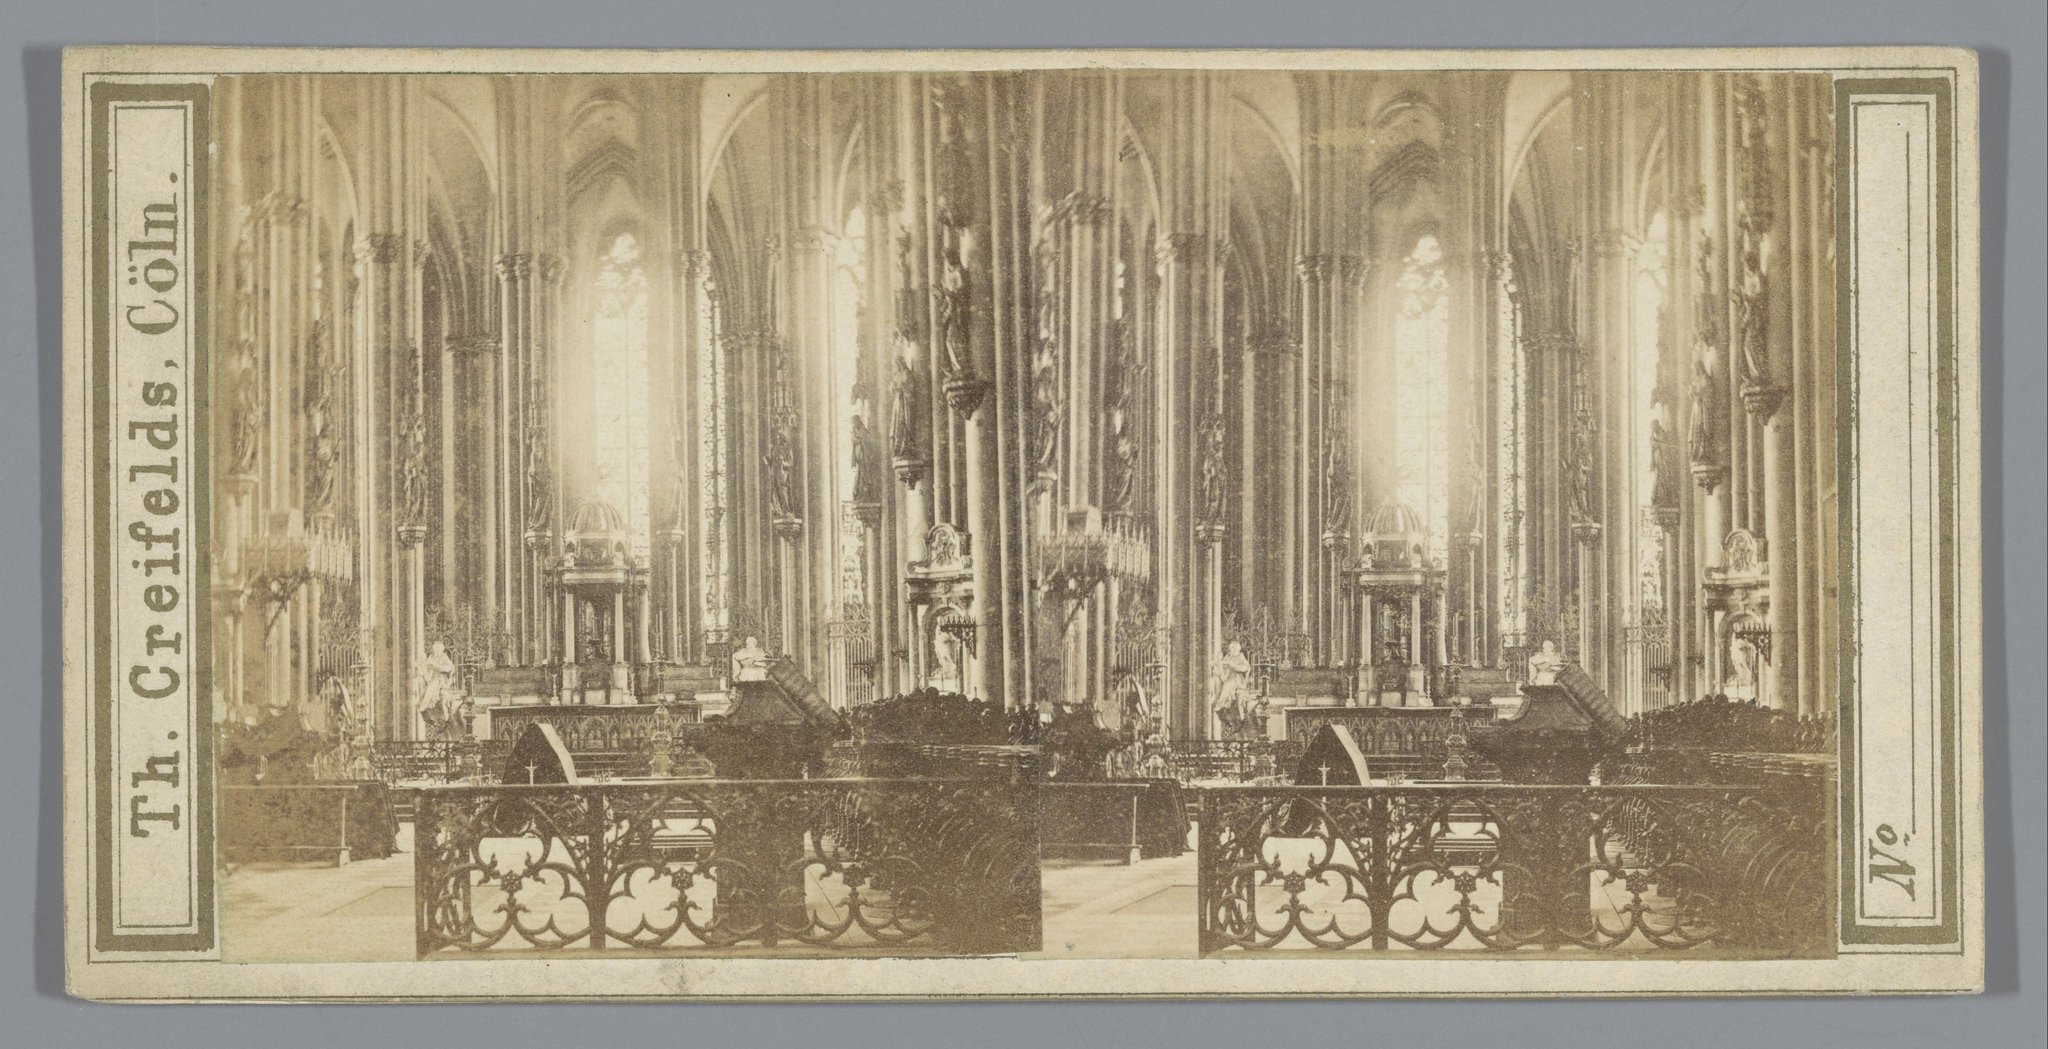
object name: stereograph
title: Koor van de Dom van Keulen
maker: theodor creifelds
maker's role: publisher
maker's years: 1815-1875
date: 1860-1880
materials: cardboard, photographic support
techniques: albumen print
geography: cologne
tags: parts of church interior: choir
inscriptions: number: ‘Nro. 11’, number: ‘No 76’